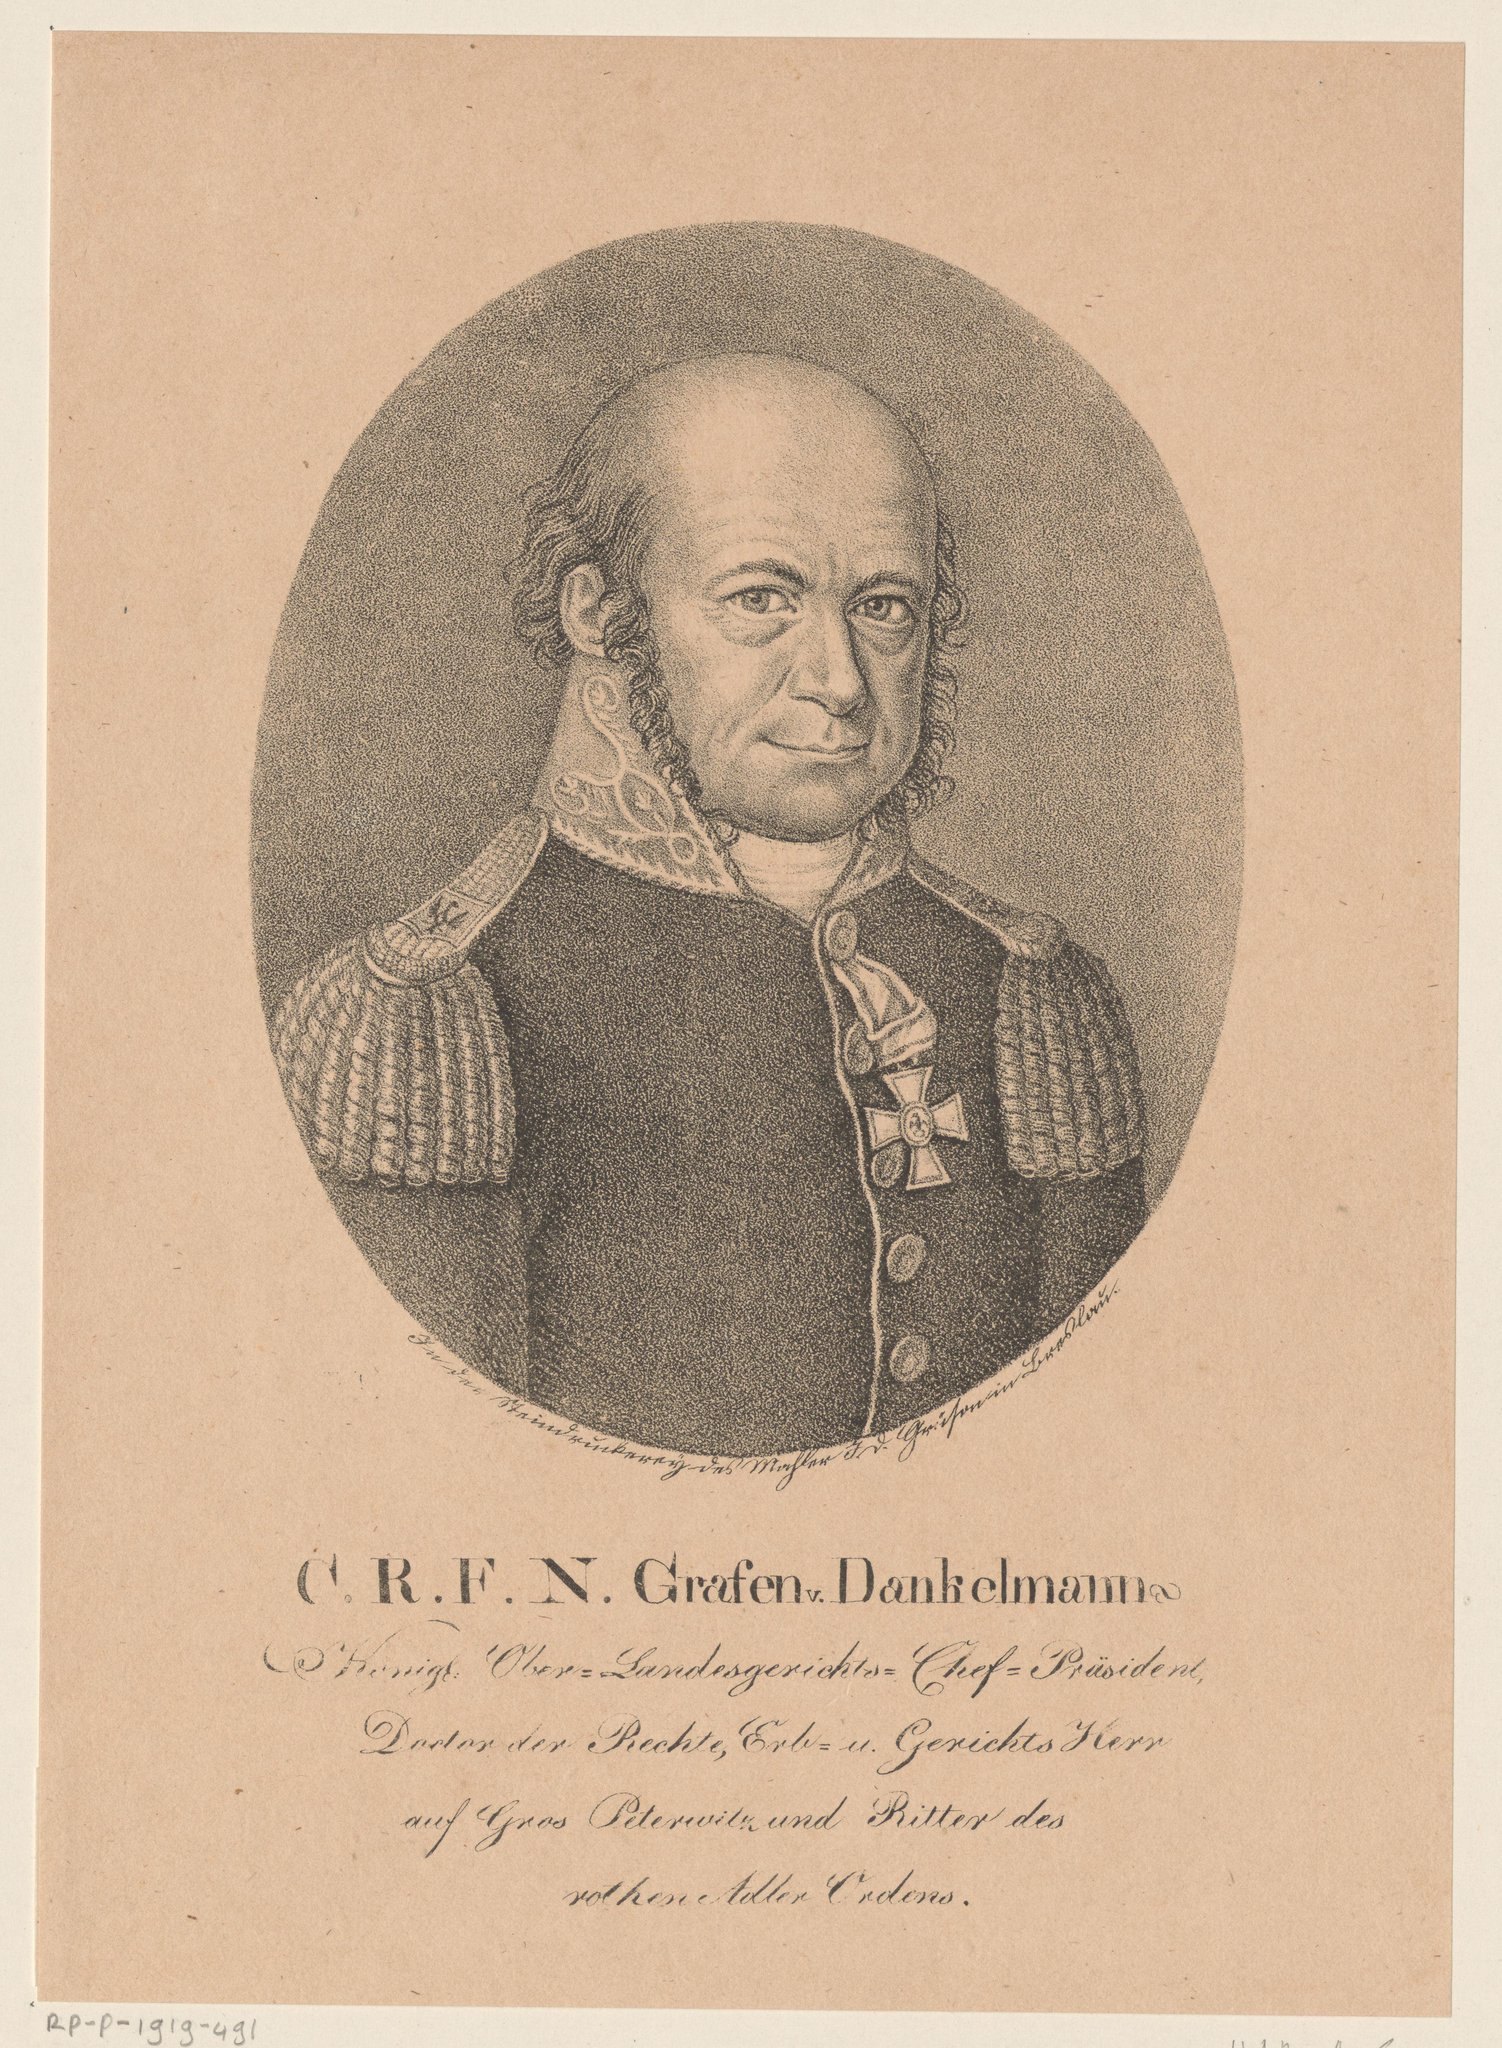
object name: print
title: Portret van C.R.F.N. graaf van Dankelmann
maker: Anonymous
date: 1800-1849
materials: paper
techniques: lithograph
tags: historical persons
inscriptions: collector's mark: Lugt 2228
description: Buste naar rechts, in uniform, in ovaal. Met onderschrift in het Duits over zijn functie.